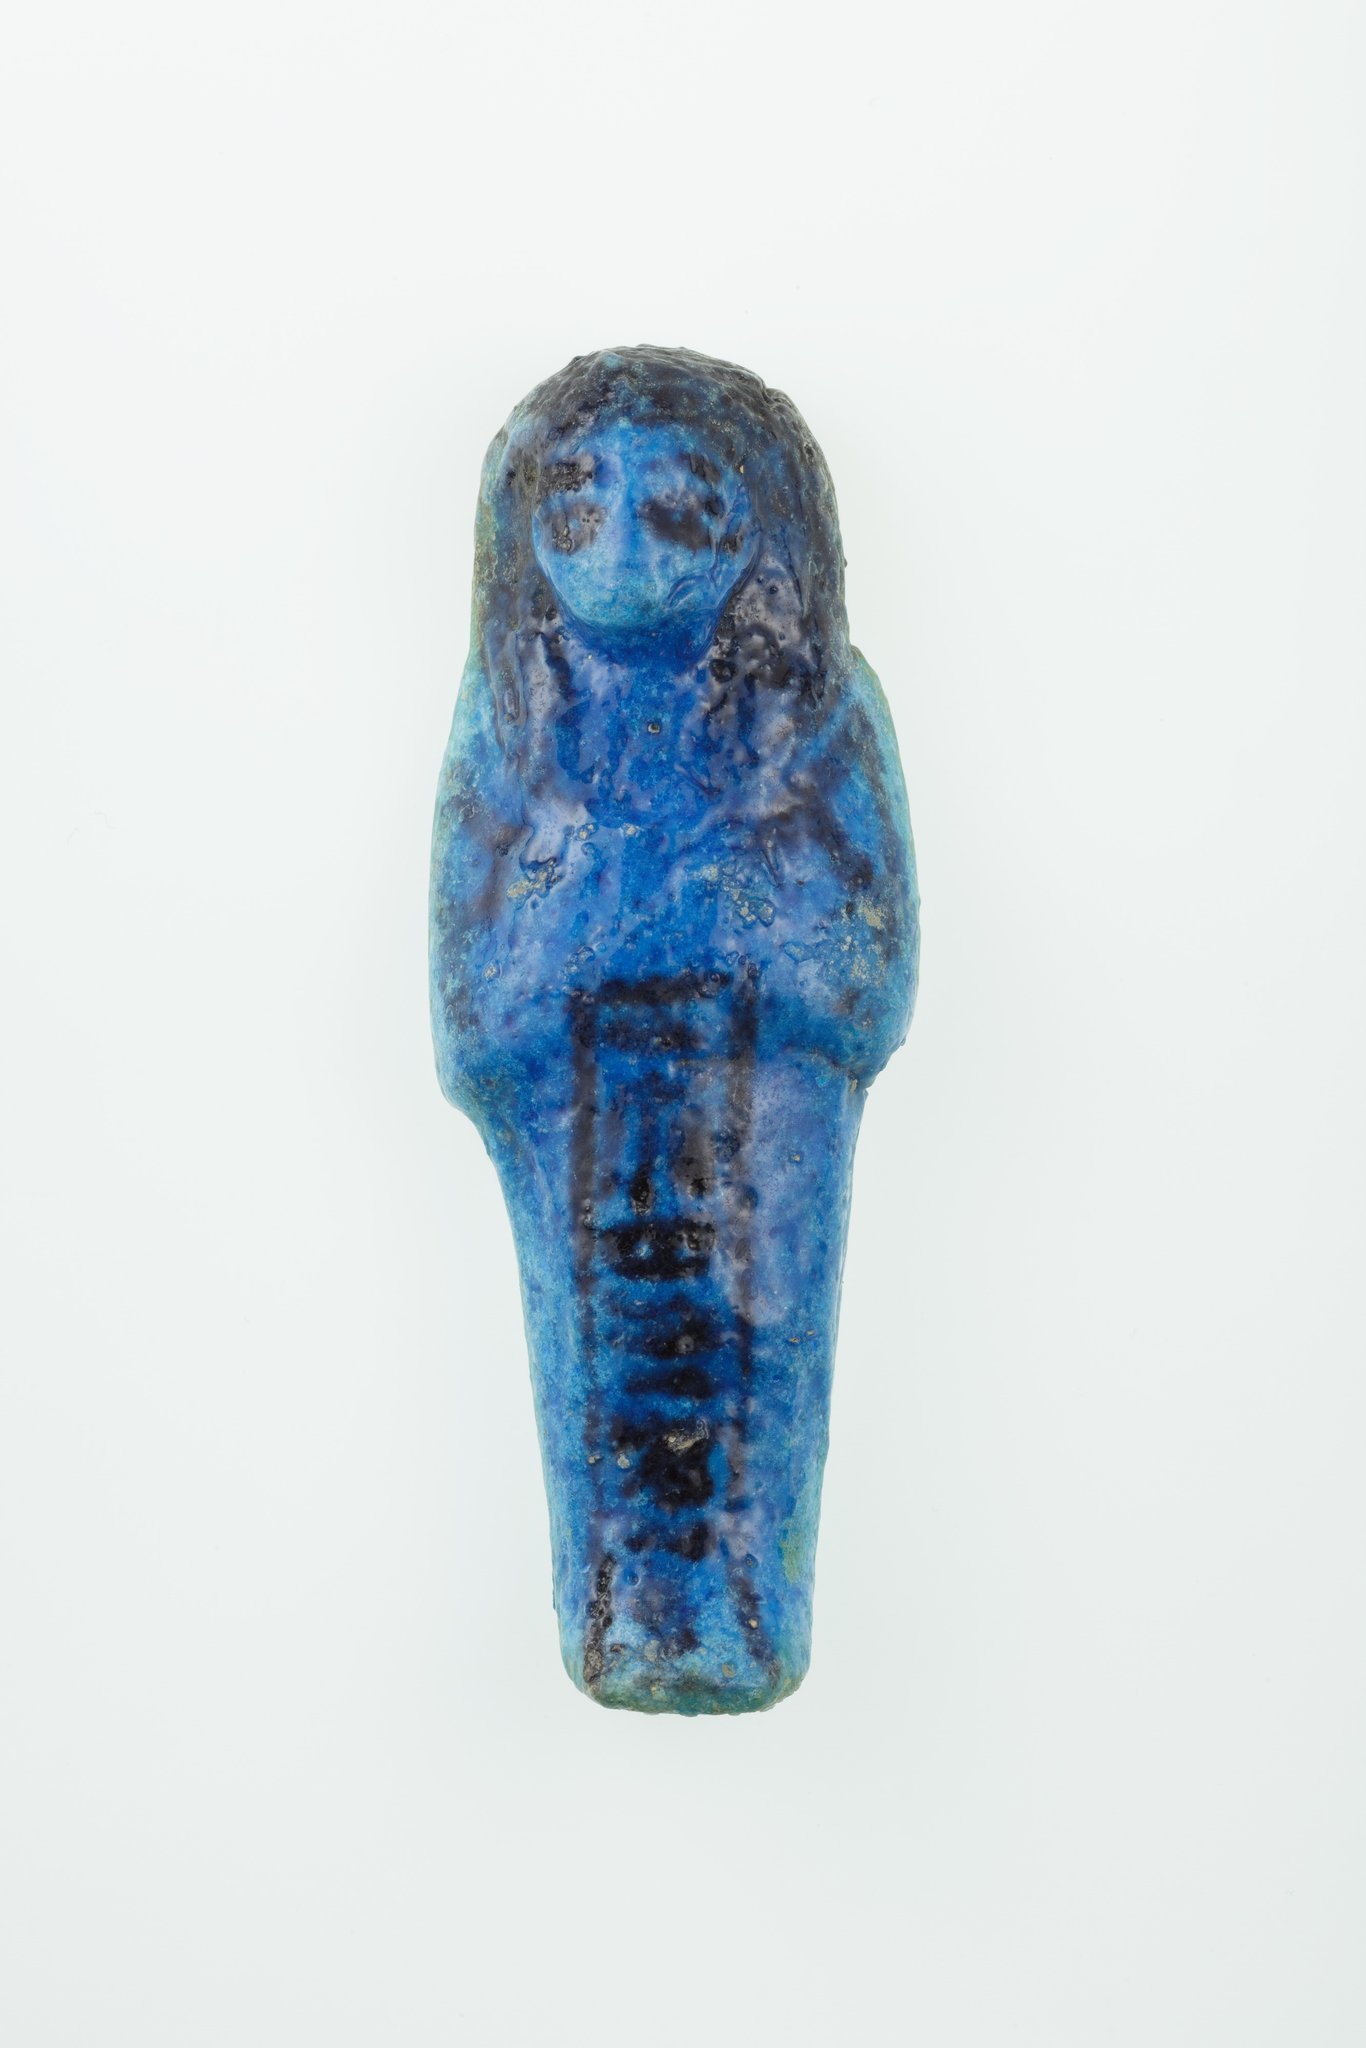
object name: shabti, worker, nauny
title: Worker Shabti of Nauny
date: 1050 BCE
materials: faience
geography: egypt